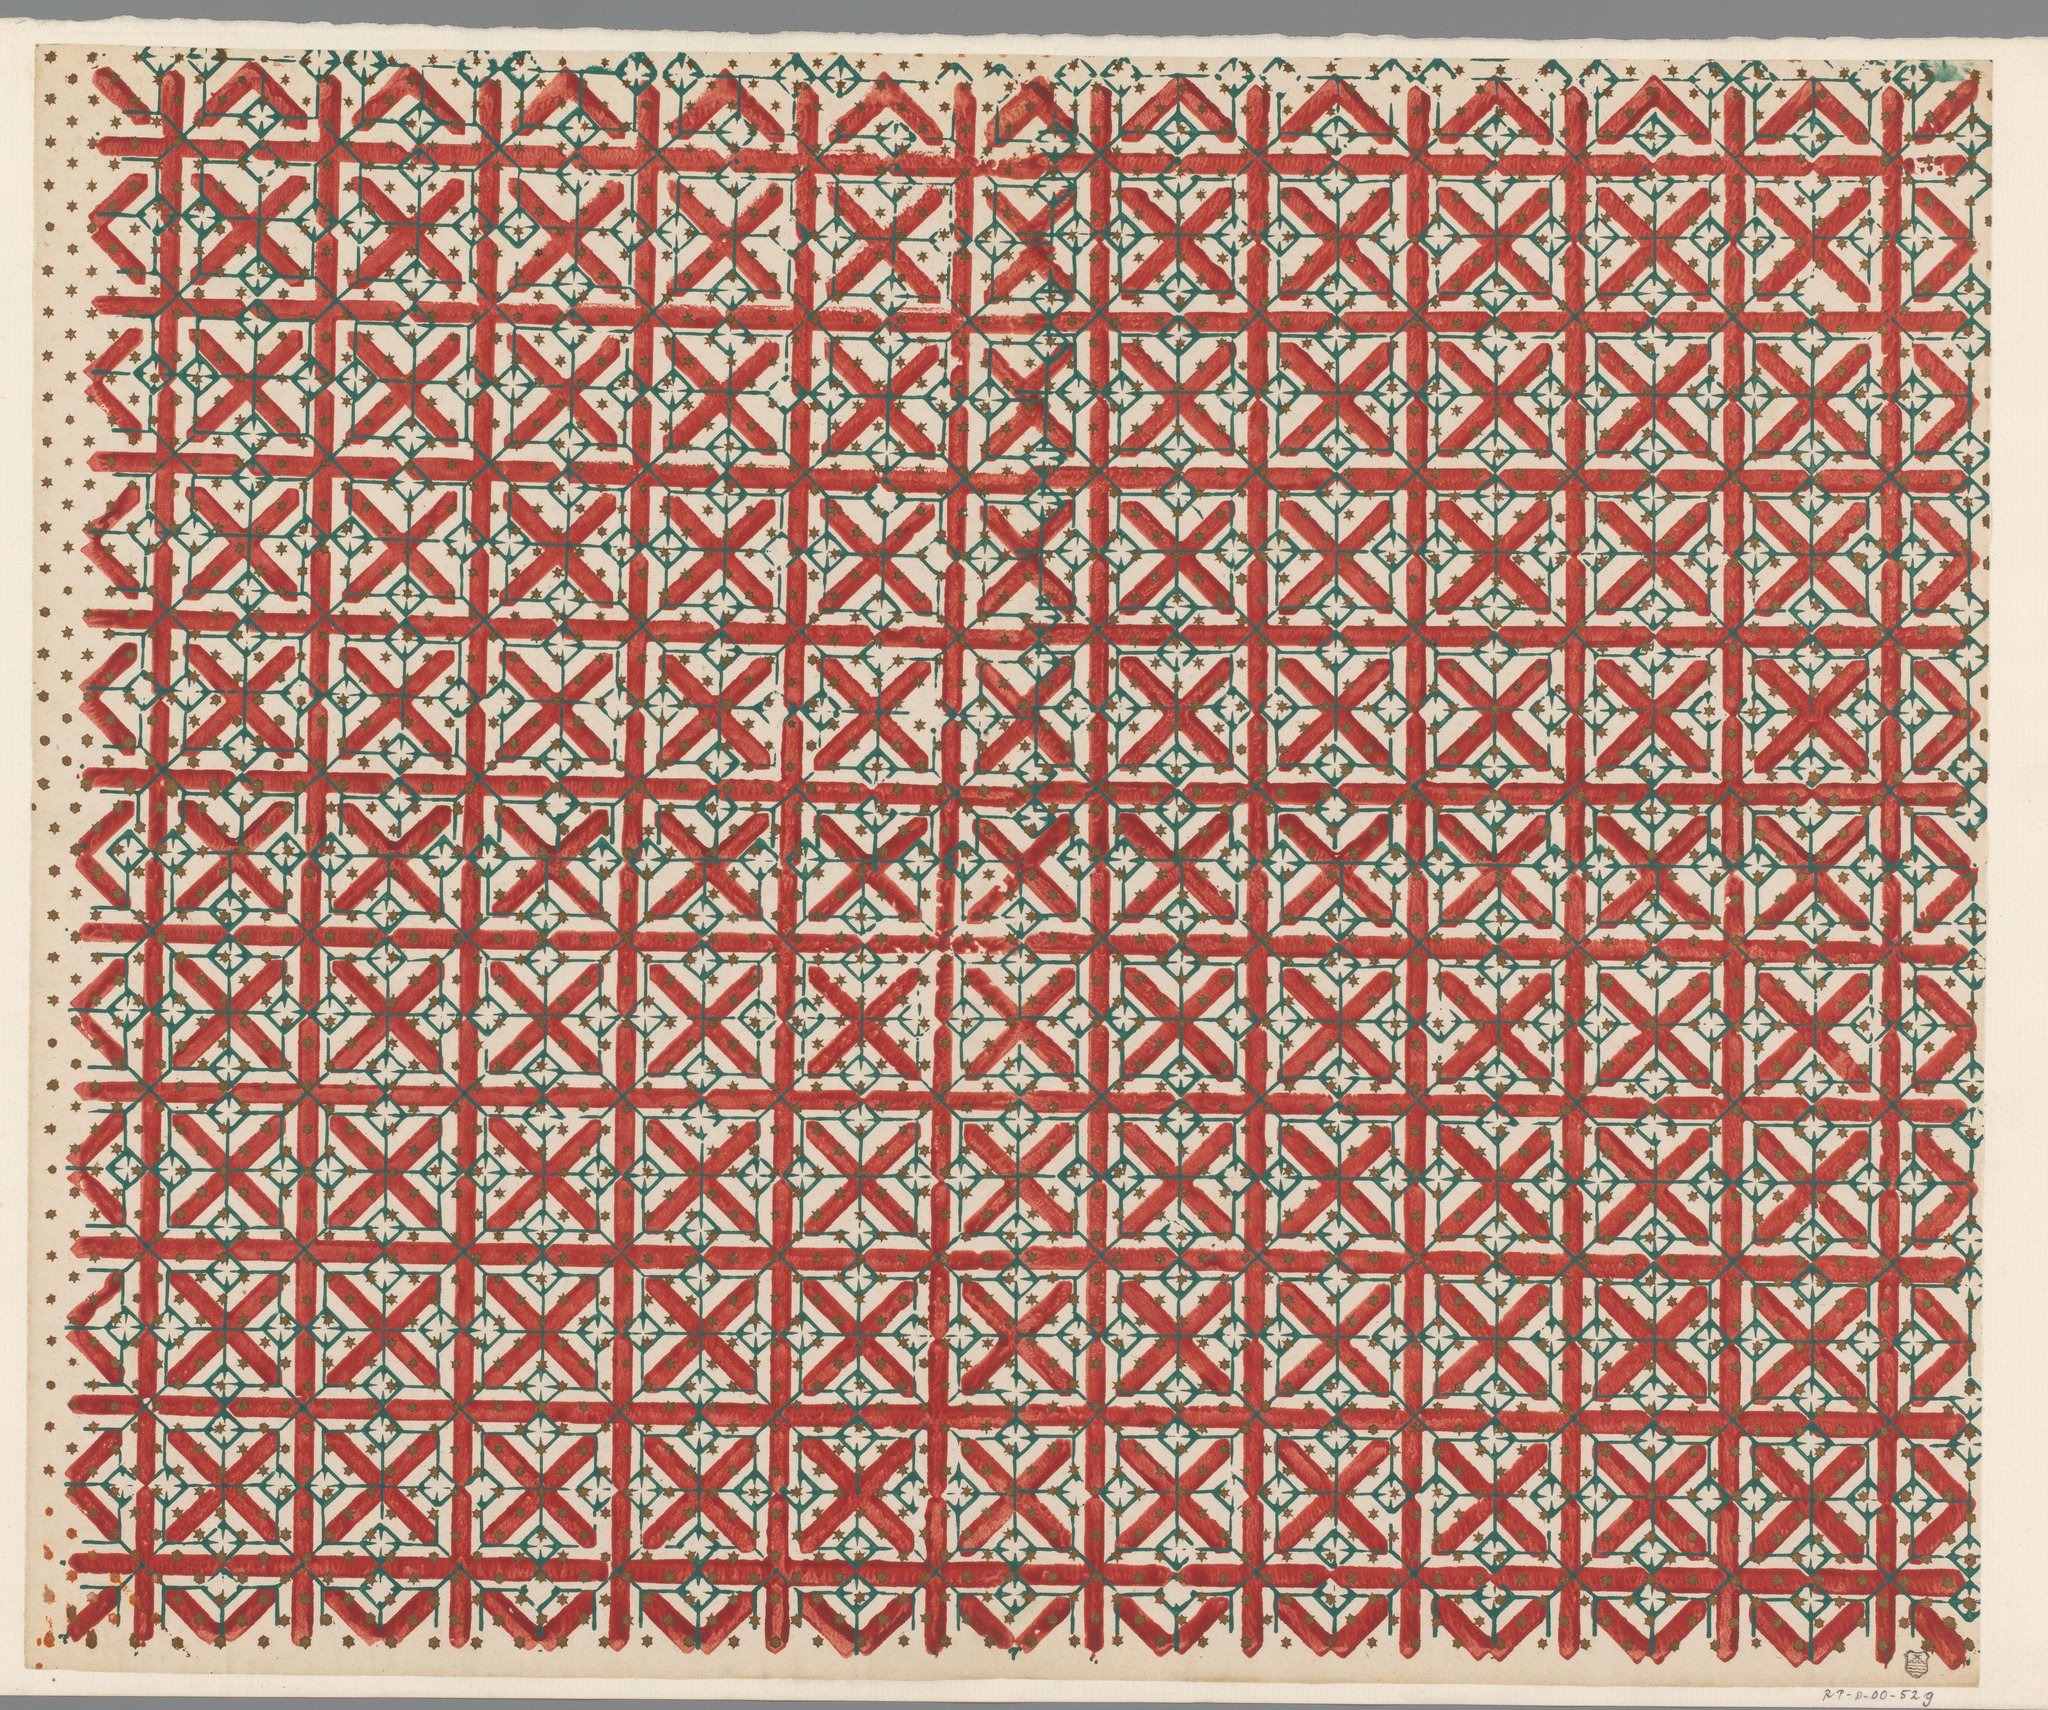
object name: printed paper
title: Blad met strooipatroon van sterretjes over lijnenraster over blokkenpatroon met kruis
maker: Anonymous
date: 1800-1900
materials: paint, paper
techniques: printing block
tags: ornament ~ geometric motifs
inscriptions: collector's mark: Lugt 2760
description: Blad met strooipatroon van sterretjes gedrukt over een rechthoekig lijnenraster gedrukt over een blokkenpatroon van vierkanten met een kruis. Gedrukt in drie drukgangen.